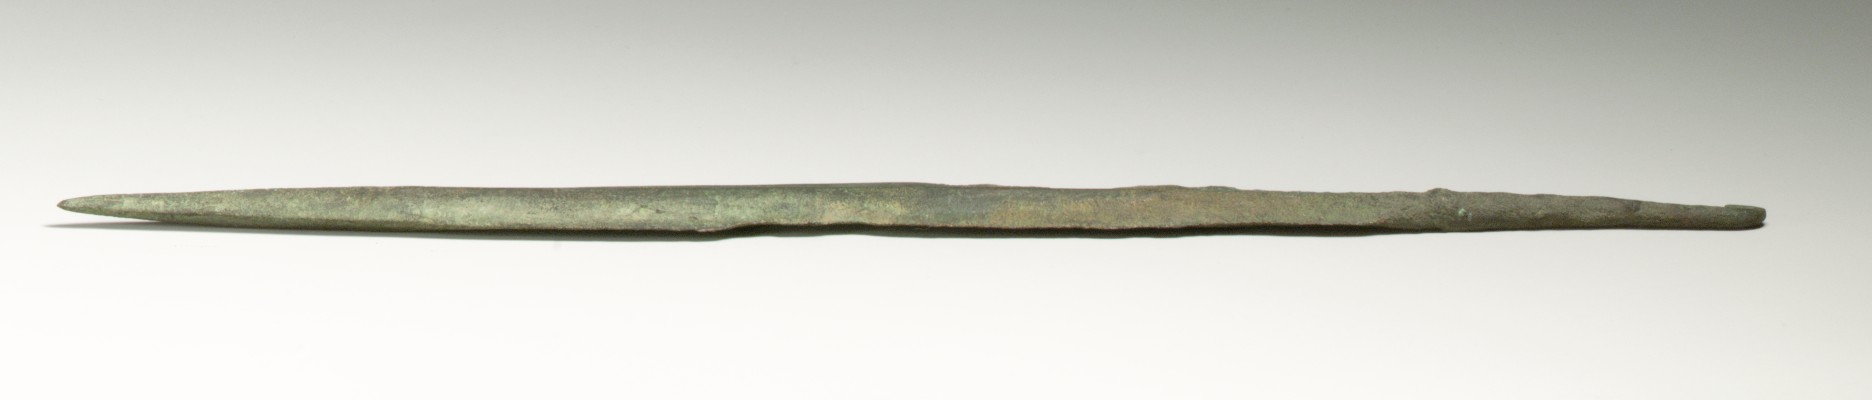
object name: dagger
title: Copper alloy spearhead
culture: cypriot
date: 2500-2000 BCE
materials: bronze